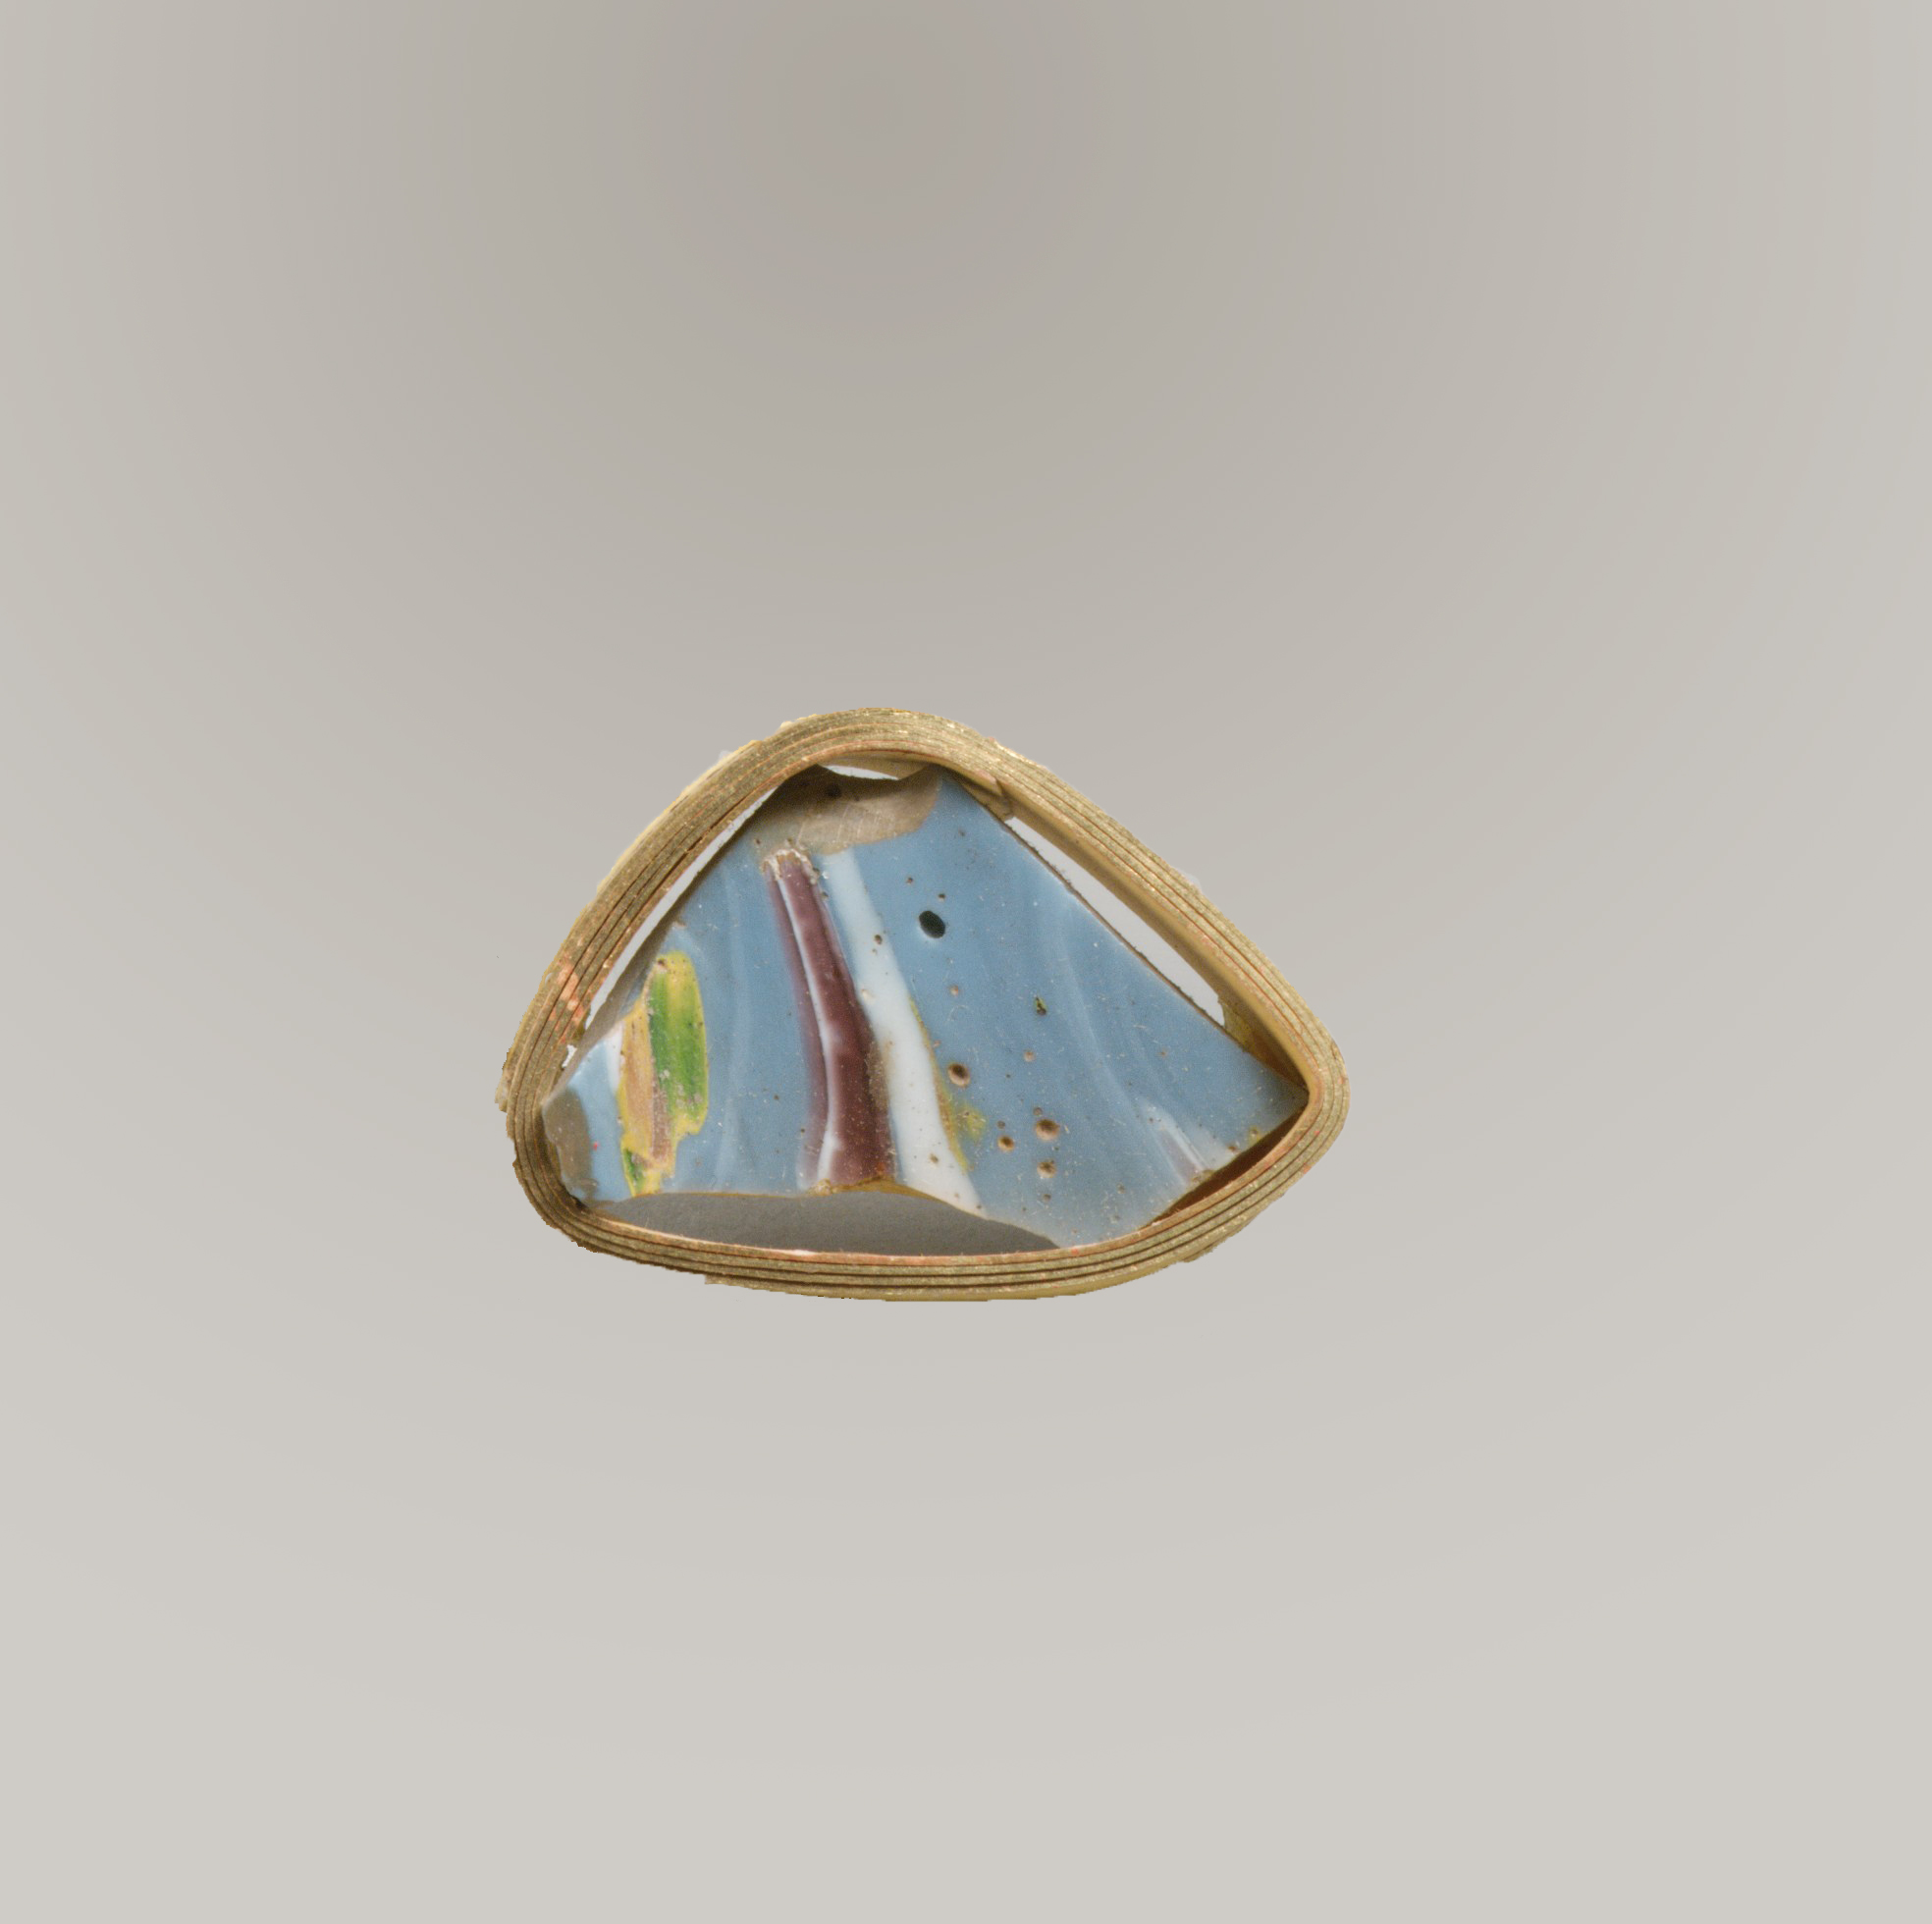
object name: fragment, mosaic dish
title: Glass mosaic dish fragment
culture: roman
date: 34 BCE-33 CE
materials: glass